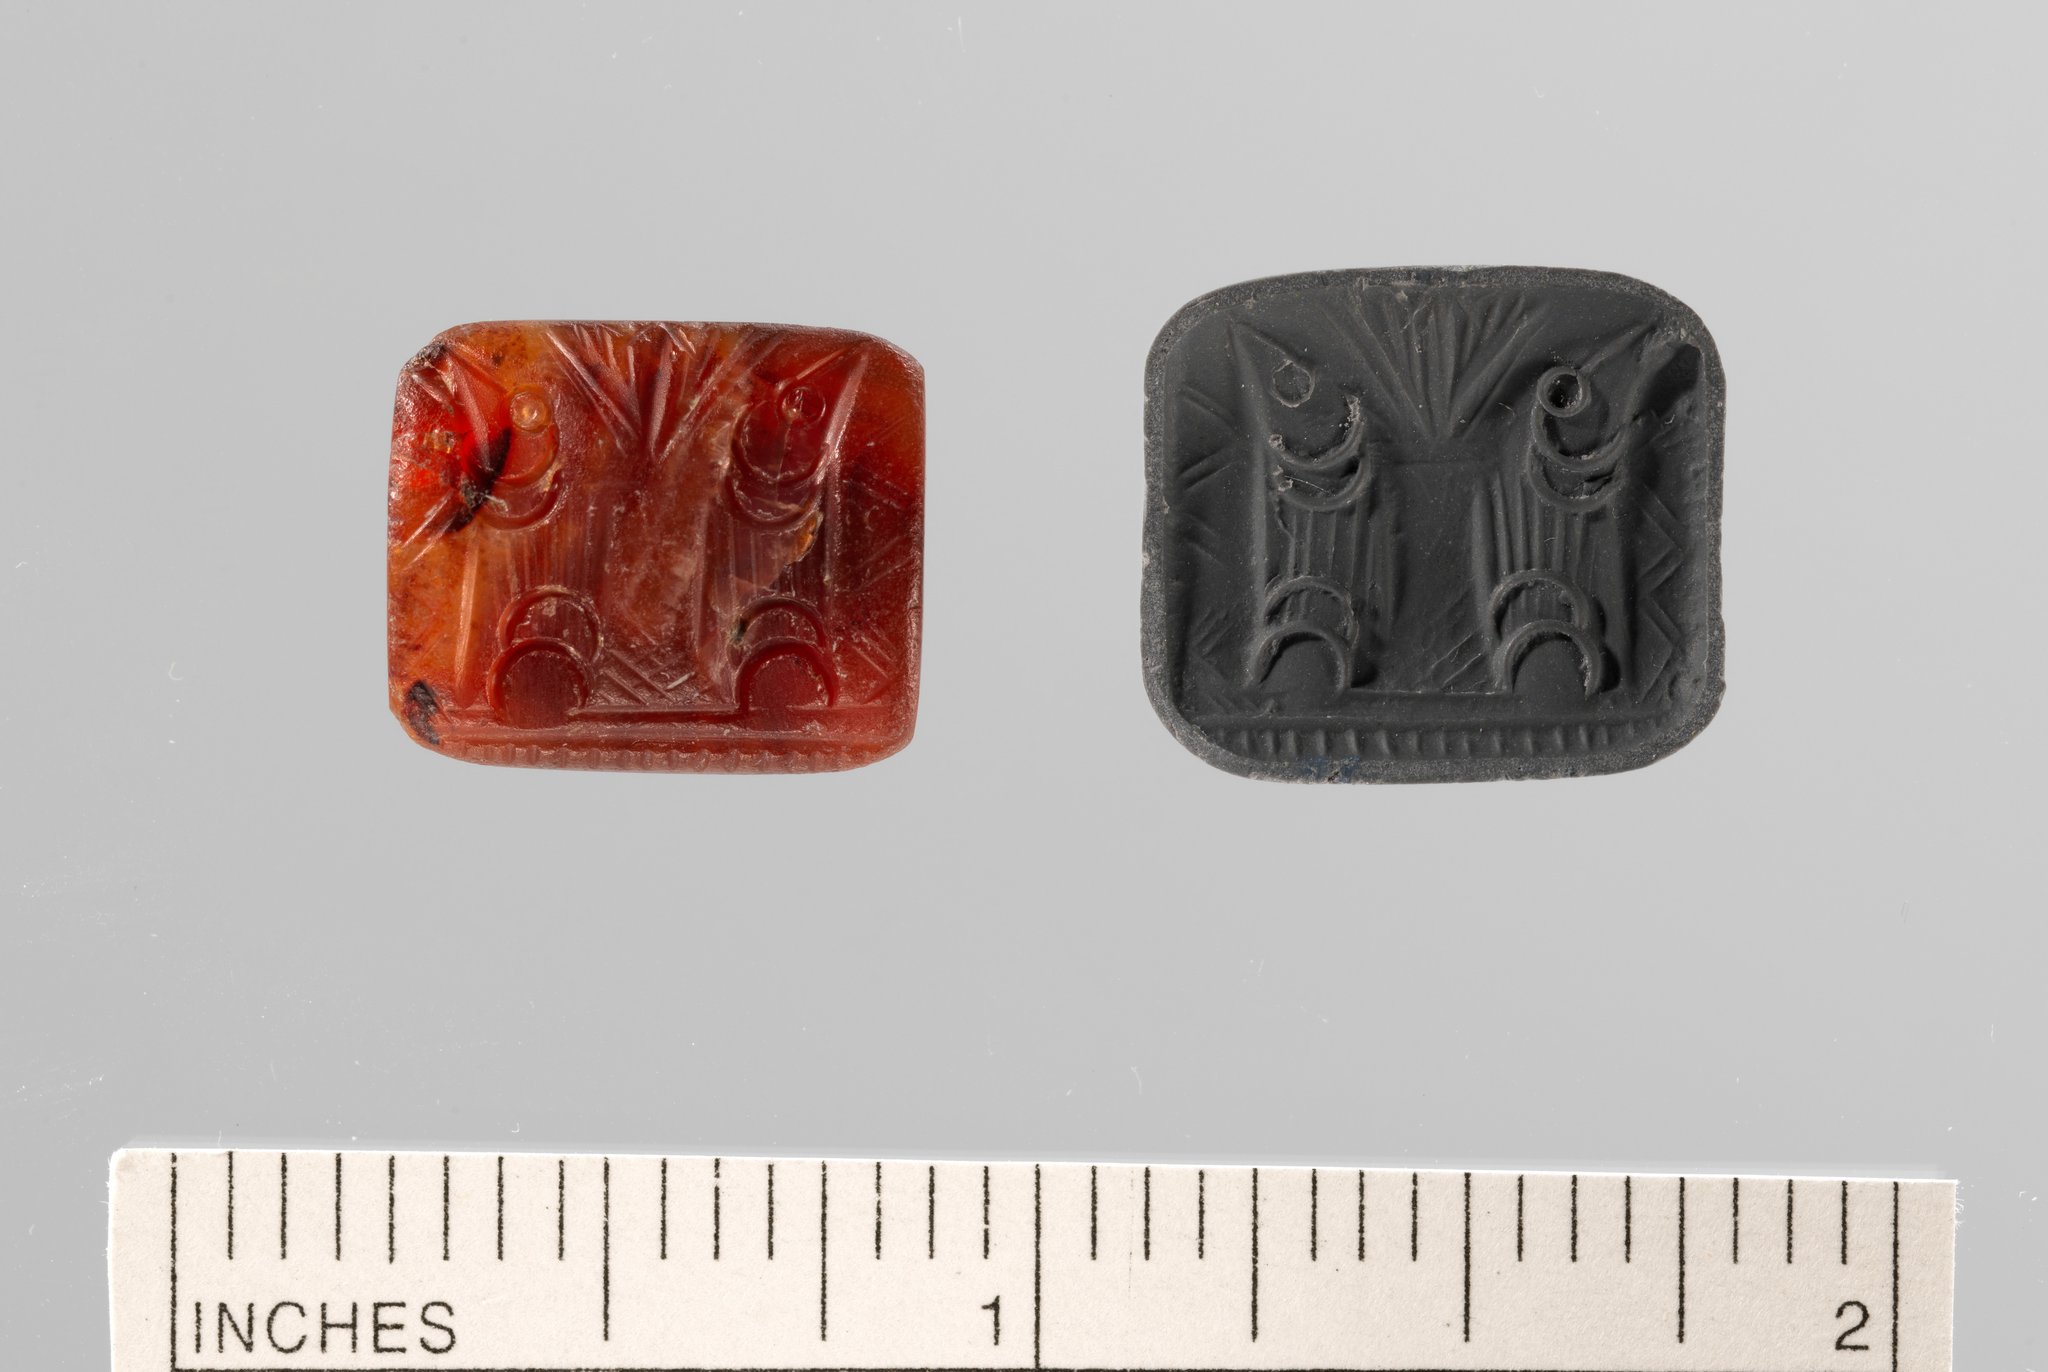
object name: seal, cushion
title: Carnelian Cushion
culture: minoan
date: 1650-1500 BCE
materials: gemstone